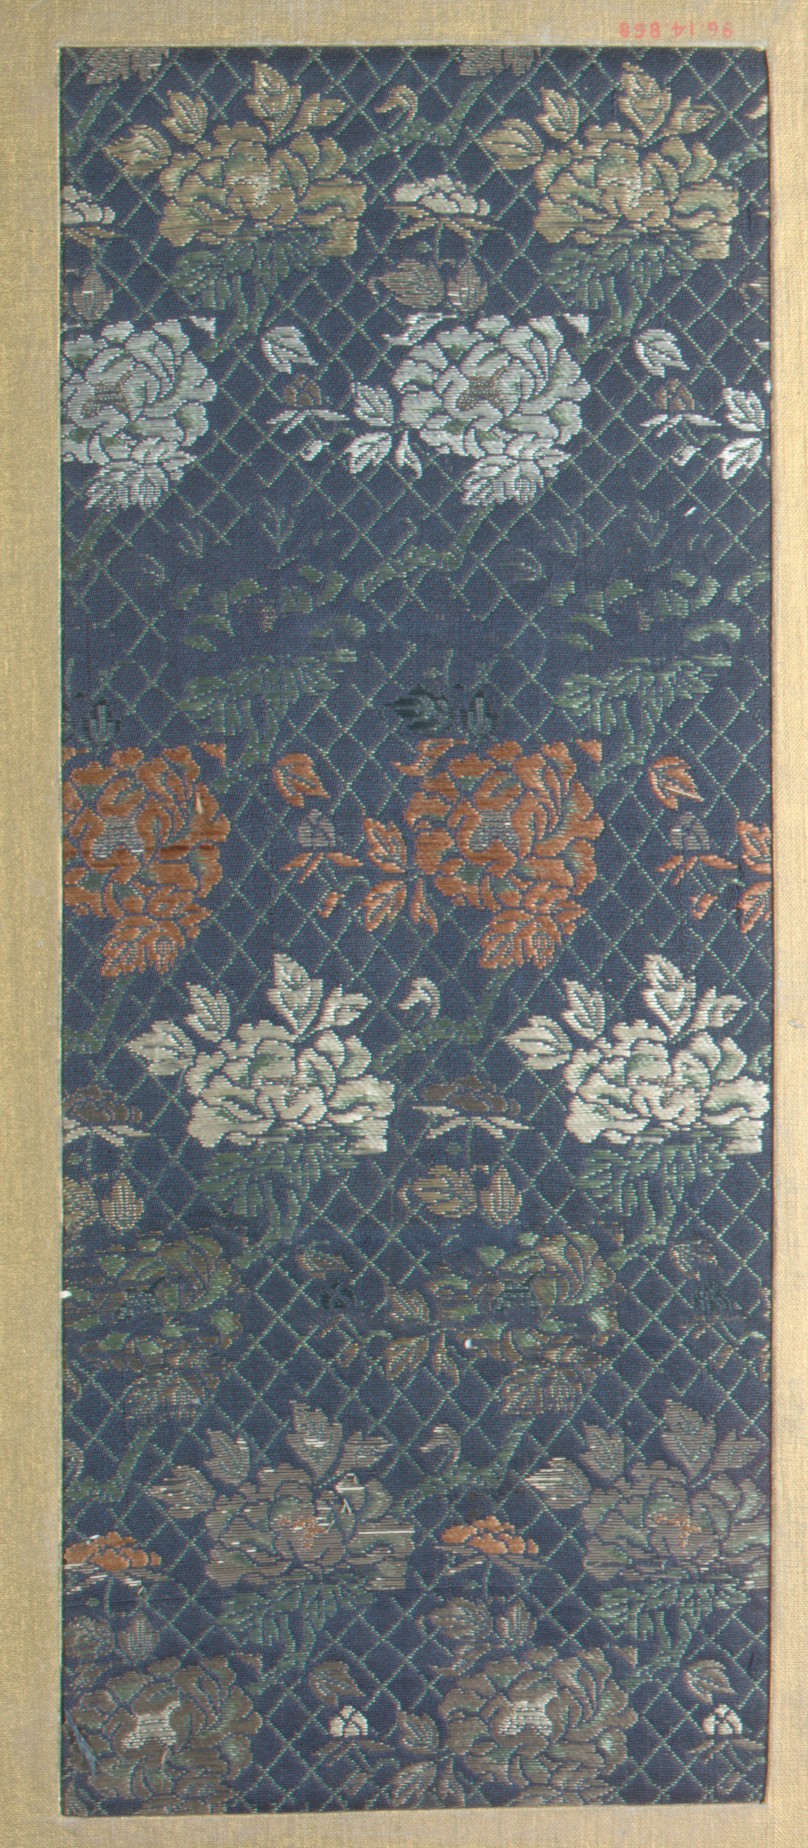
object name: piece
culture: japanese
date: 1701-1900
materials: silk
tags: flowers